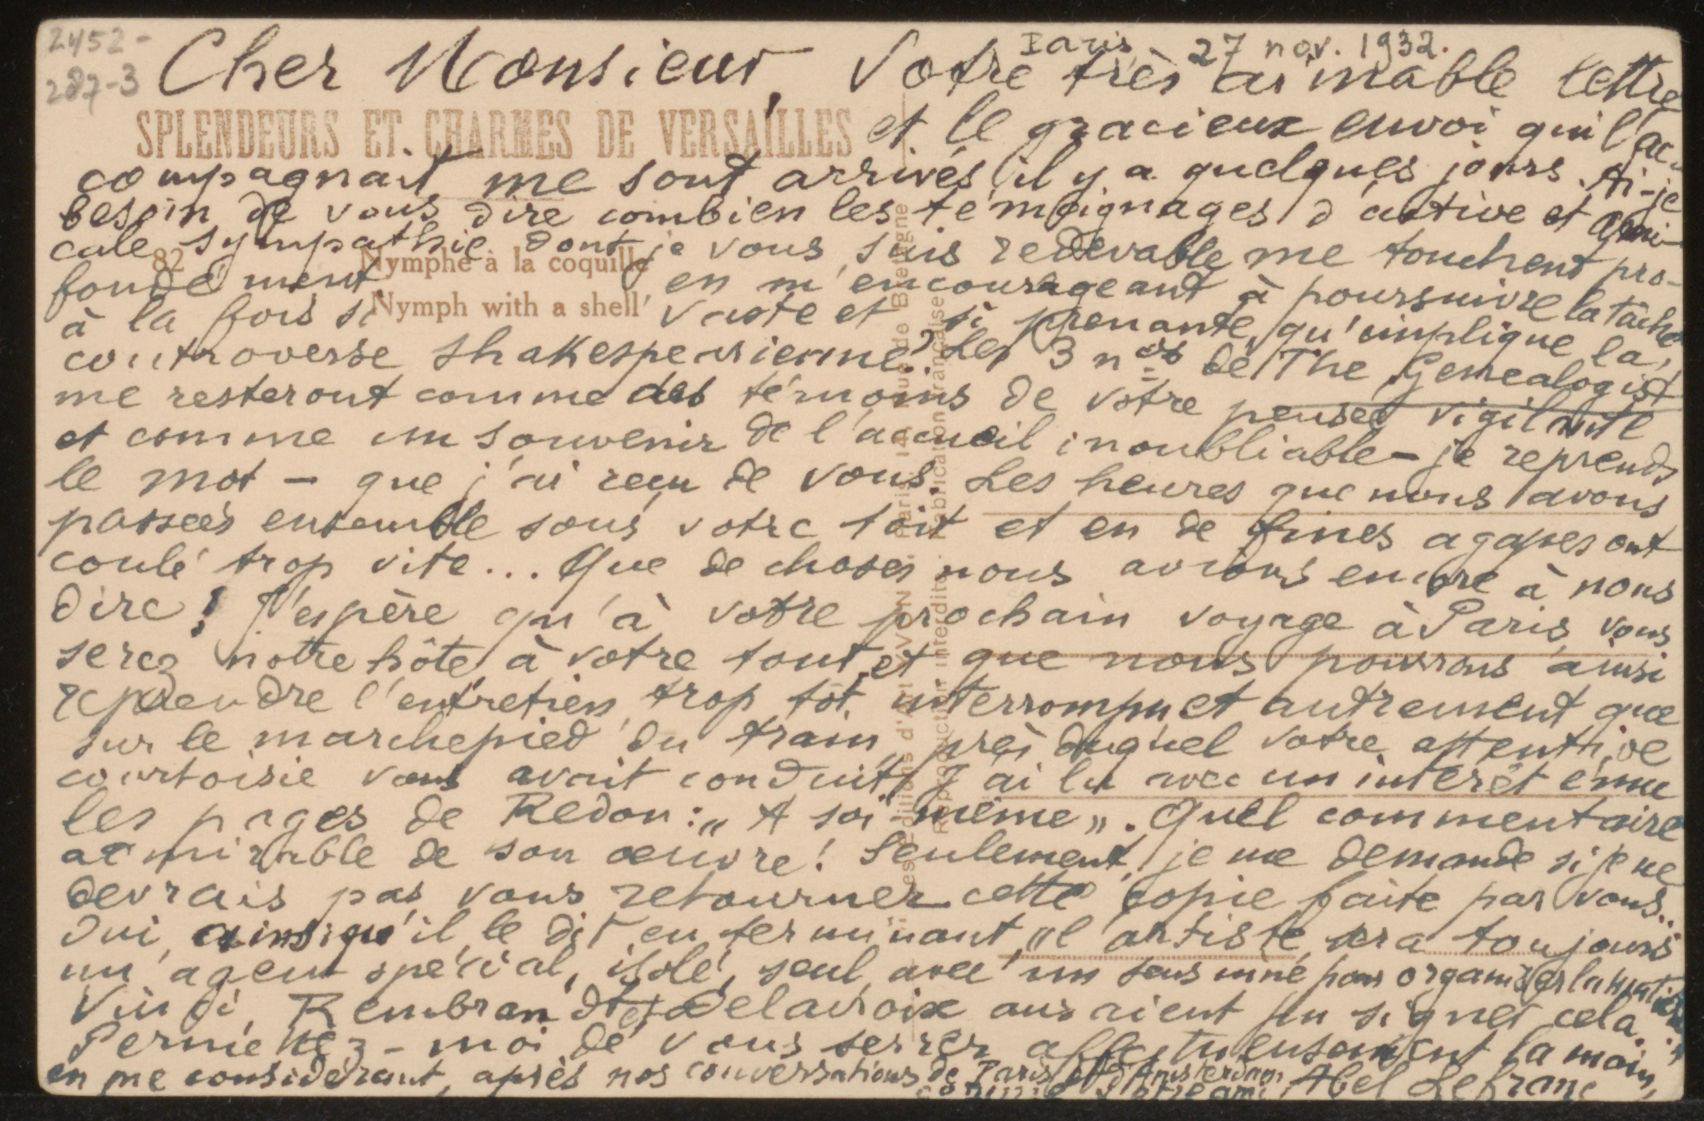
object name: ansichtkaart, prentbriefkaart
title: Prentbriefkaart aan Andries Bonger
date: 1932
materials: cardboard, ink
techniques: pen, rotogravure, writing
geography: france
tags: odilon redon, paris, print maker, draughtsman, eugène delacroix, leiden, amsterdam, painter, rembrandt van rijn, andries bonger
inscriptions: seal